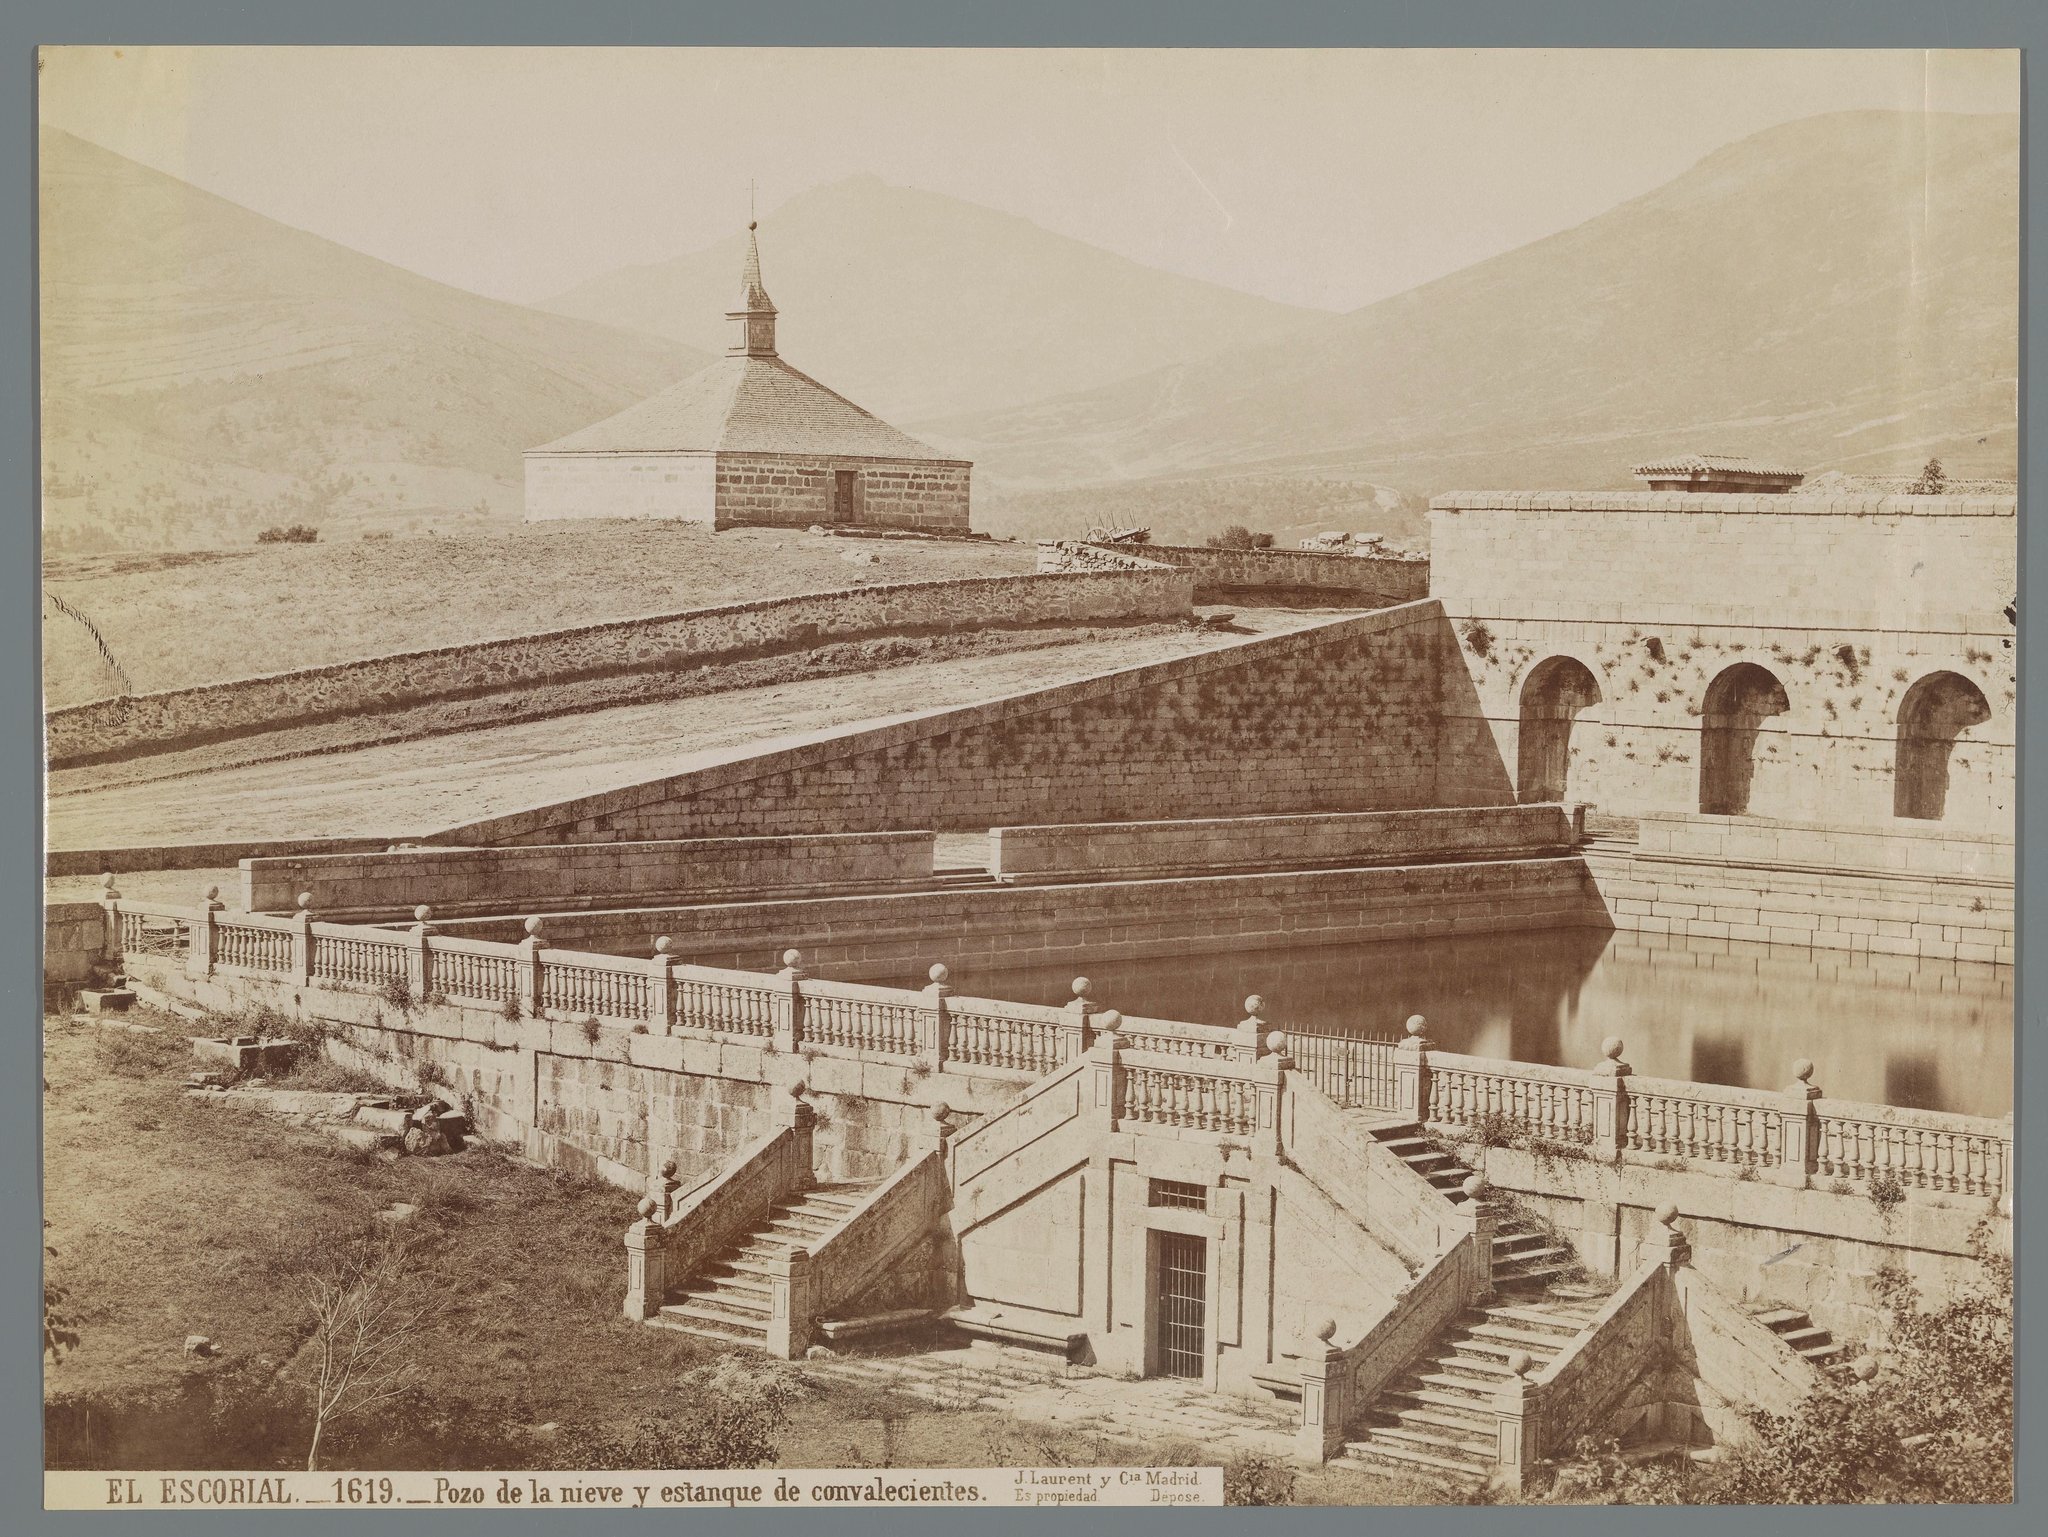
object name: photograph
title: El Escorial, pozo de la nieve y estanque de convalecientes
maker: juan laurent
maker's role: publisher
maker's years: 1816-1896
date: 1863-1883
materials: paper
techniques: albumen print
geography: san lorenzo de el escorial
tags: public baths - aa - in the open air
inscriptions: number: ‘1619.’